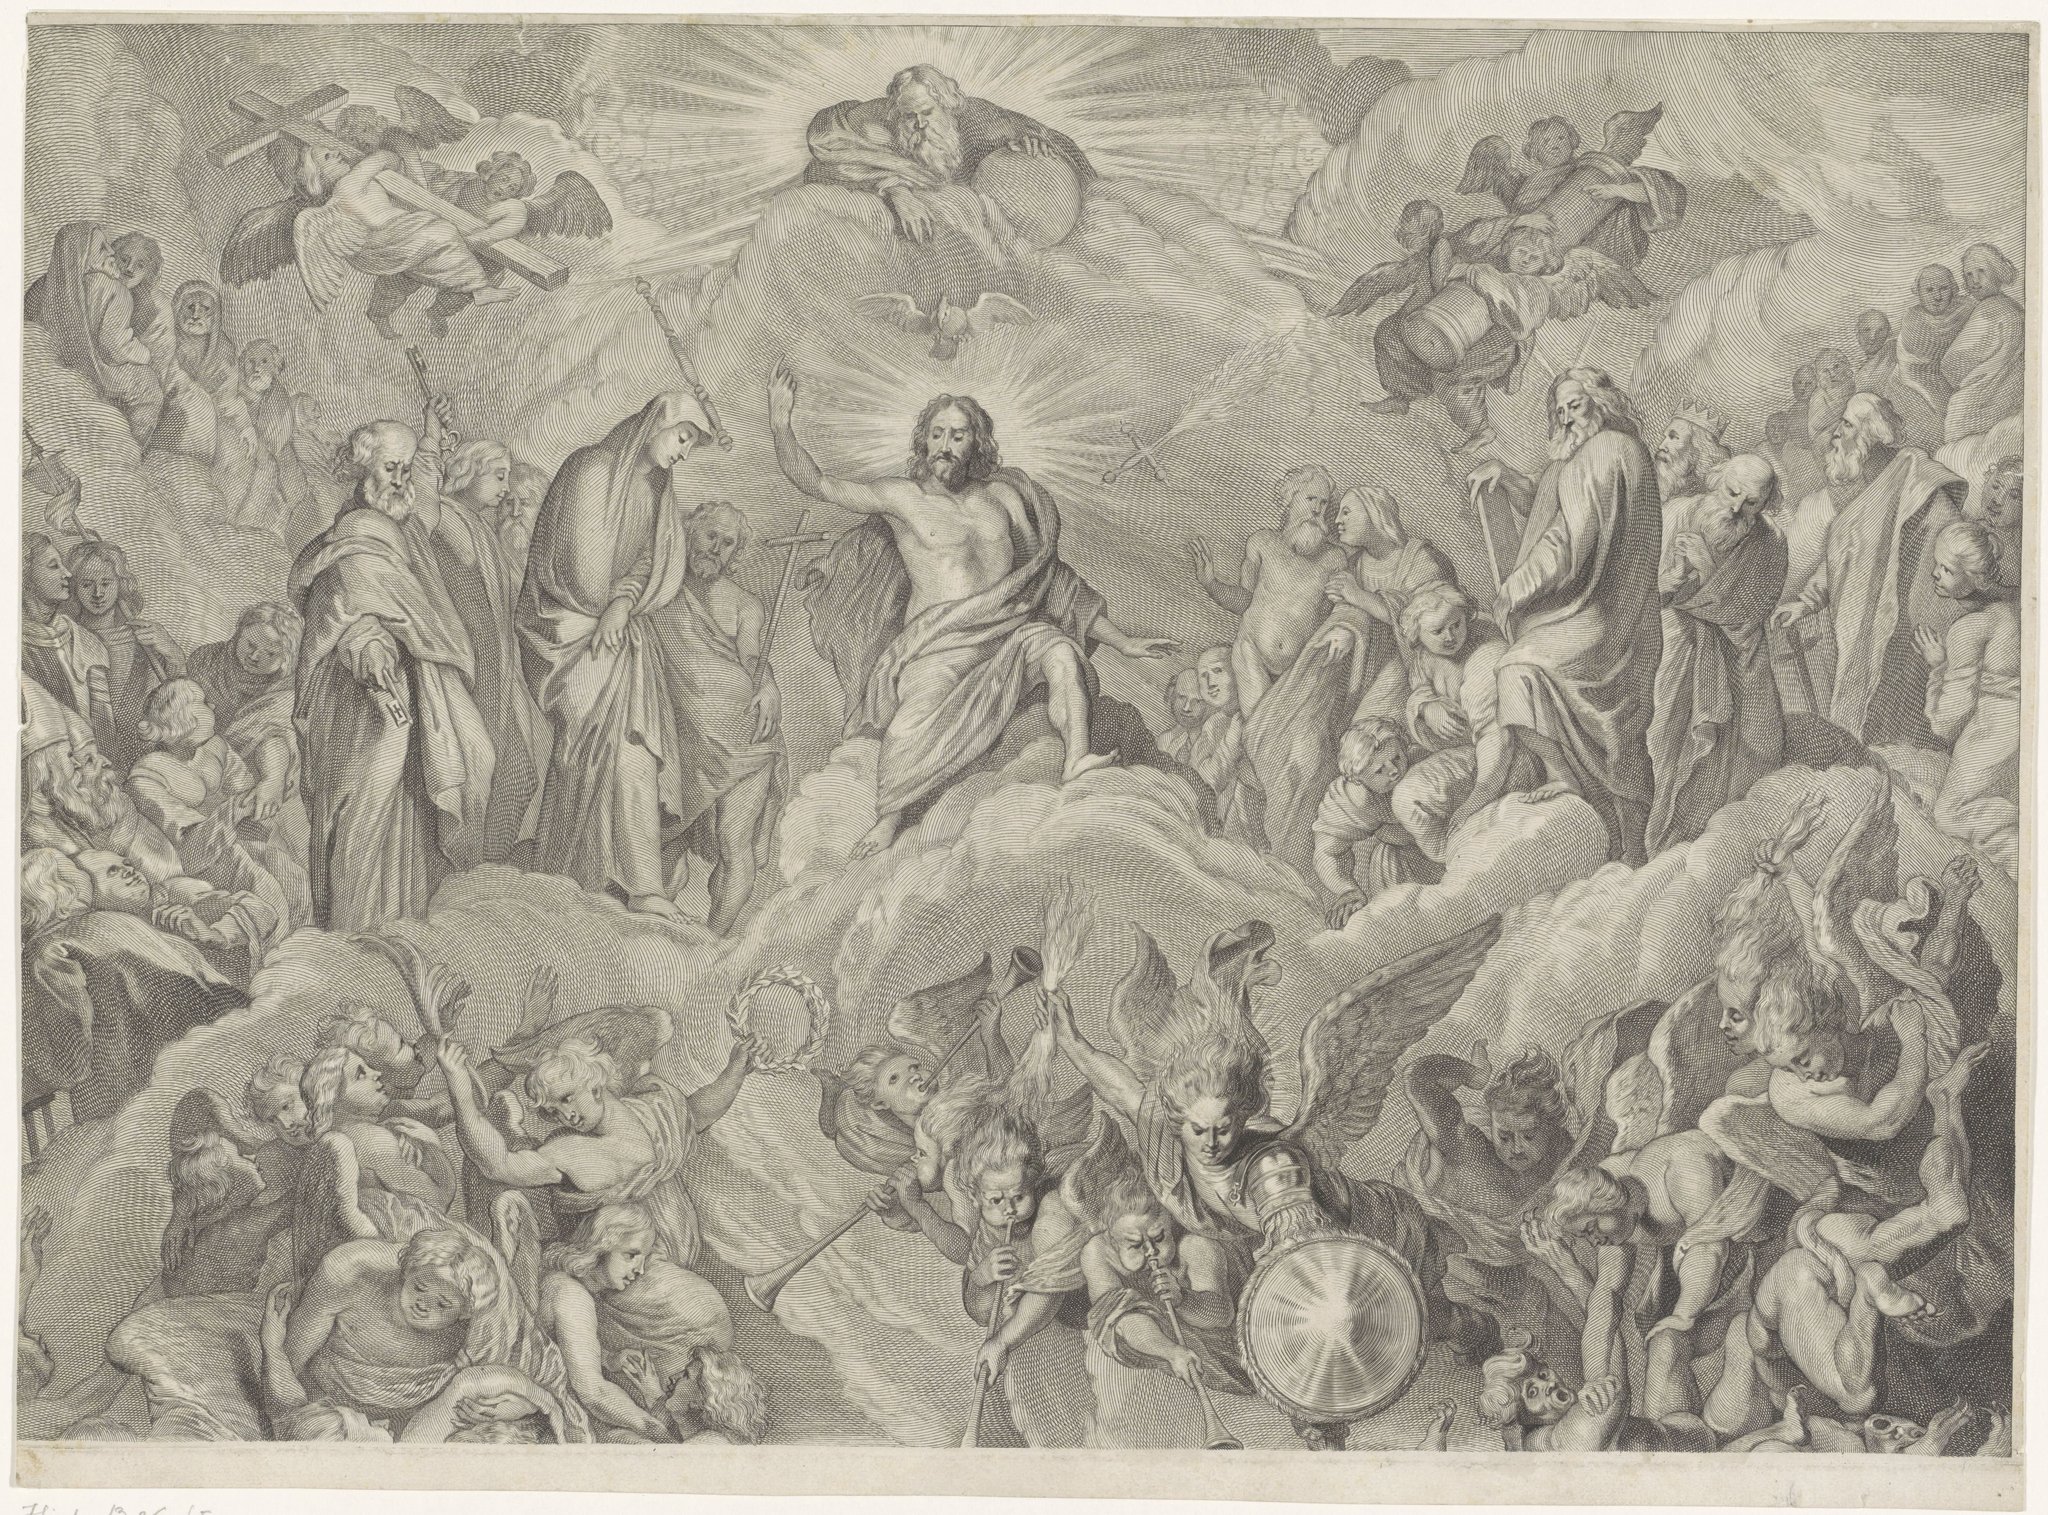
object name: print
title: Laatste Oordeel (bovenste plaat)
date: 1638-1658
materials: paper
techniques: engraving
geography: haarlem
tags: last judgement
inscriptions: collector's mark: Lugt 11, collector's mark: Lugt 10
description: Christus zit tronend als rechter op een wolk in de hemel bij het laatste oordeel. Hij maakt een spreekgebaar en wordt omringd door engelen, koningen, kerkvaders en zijn apostelen. Boven hem vliegt de duif van de Heilige Geest en ligt God met de wereldbol op een wolk.